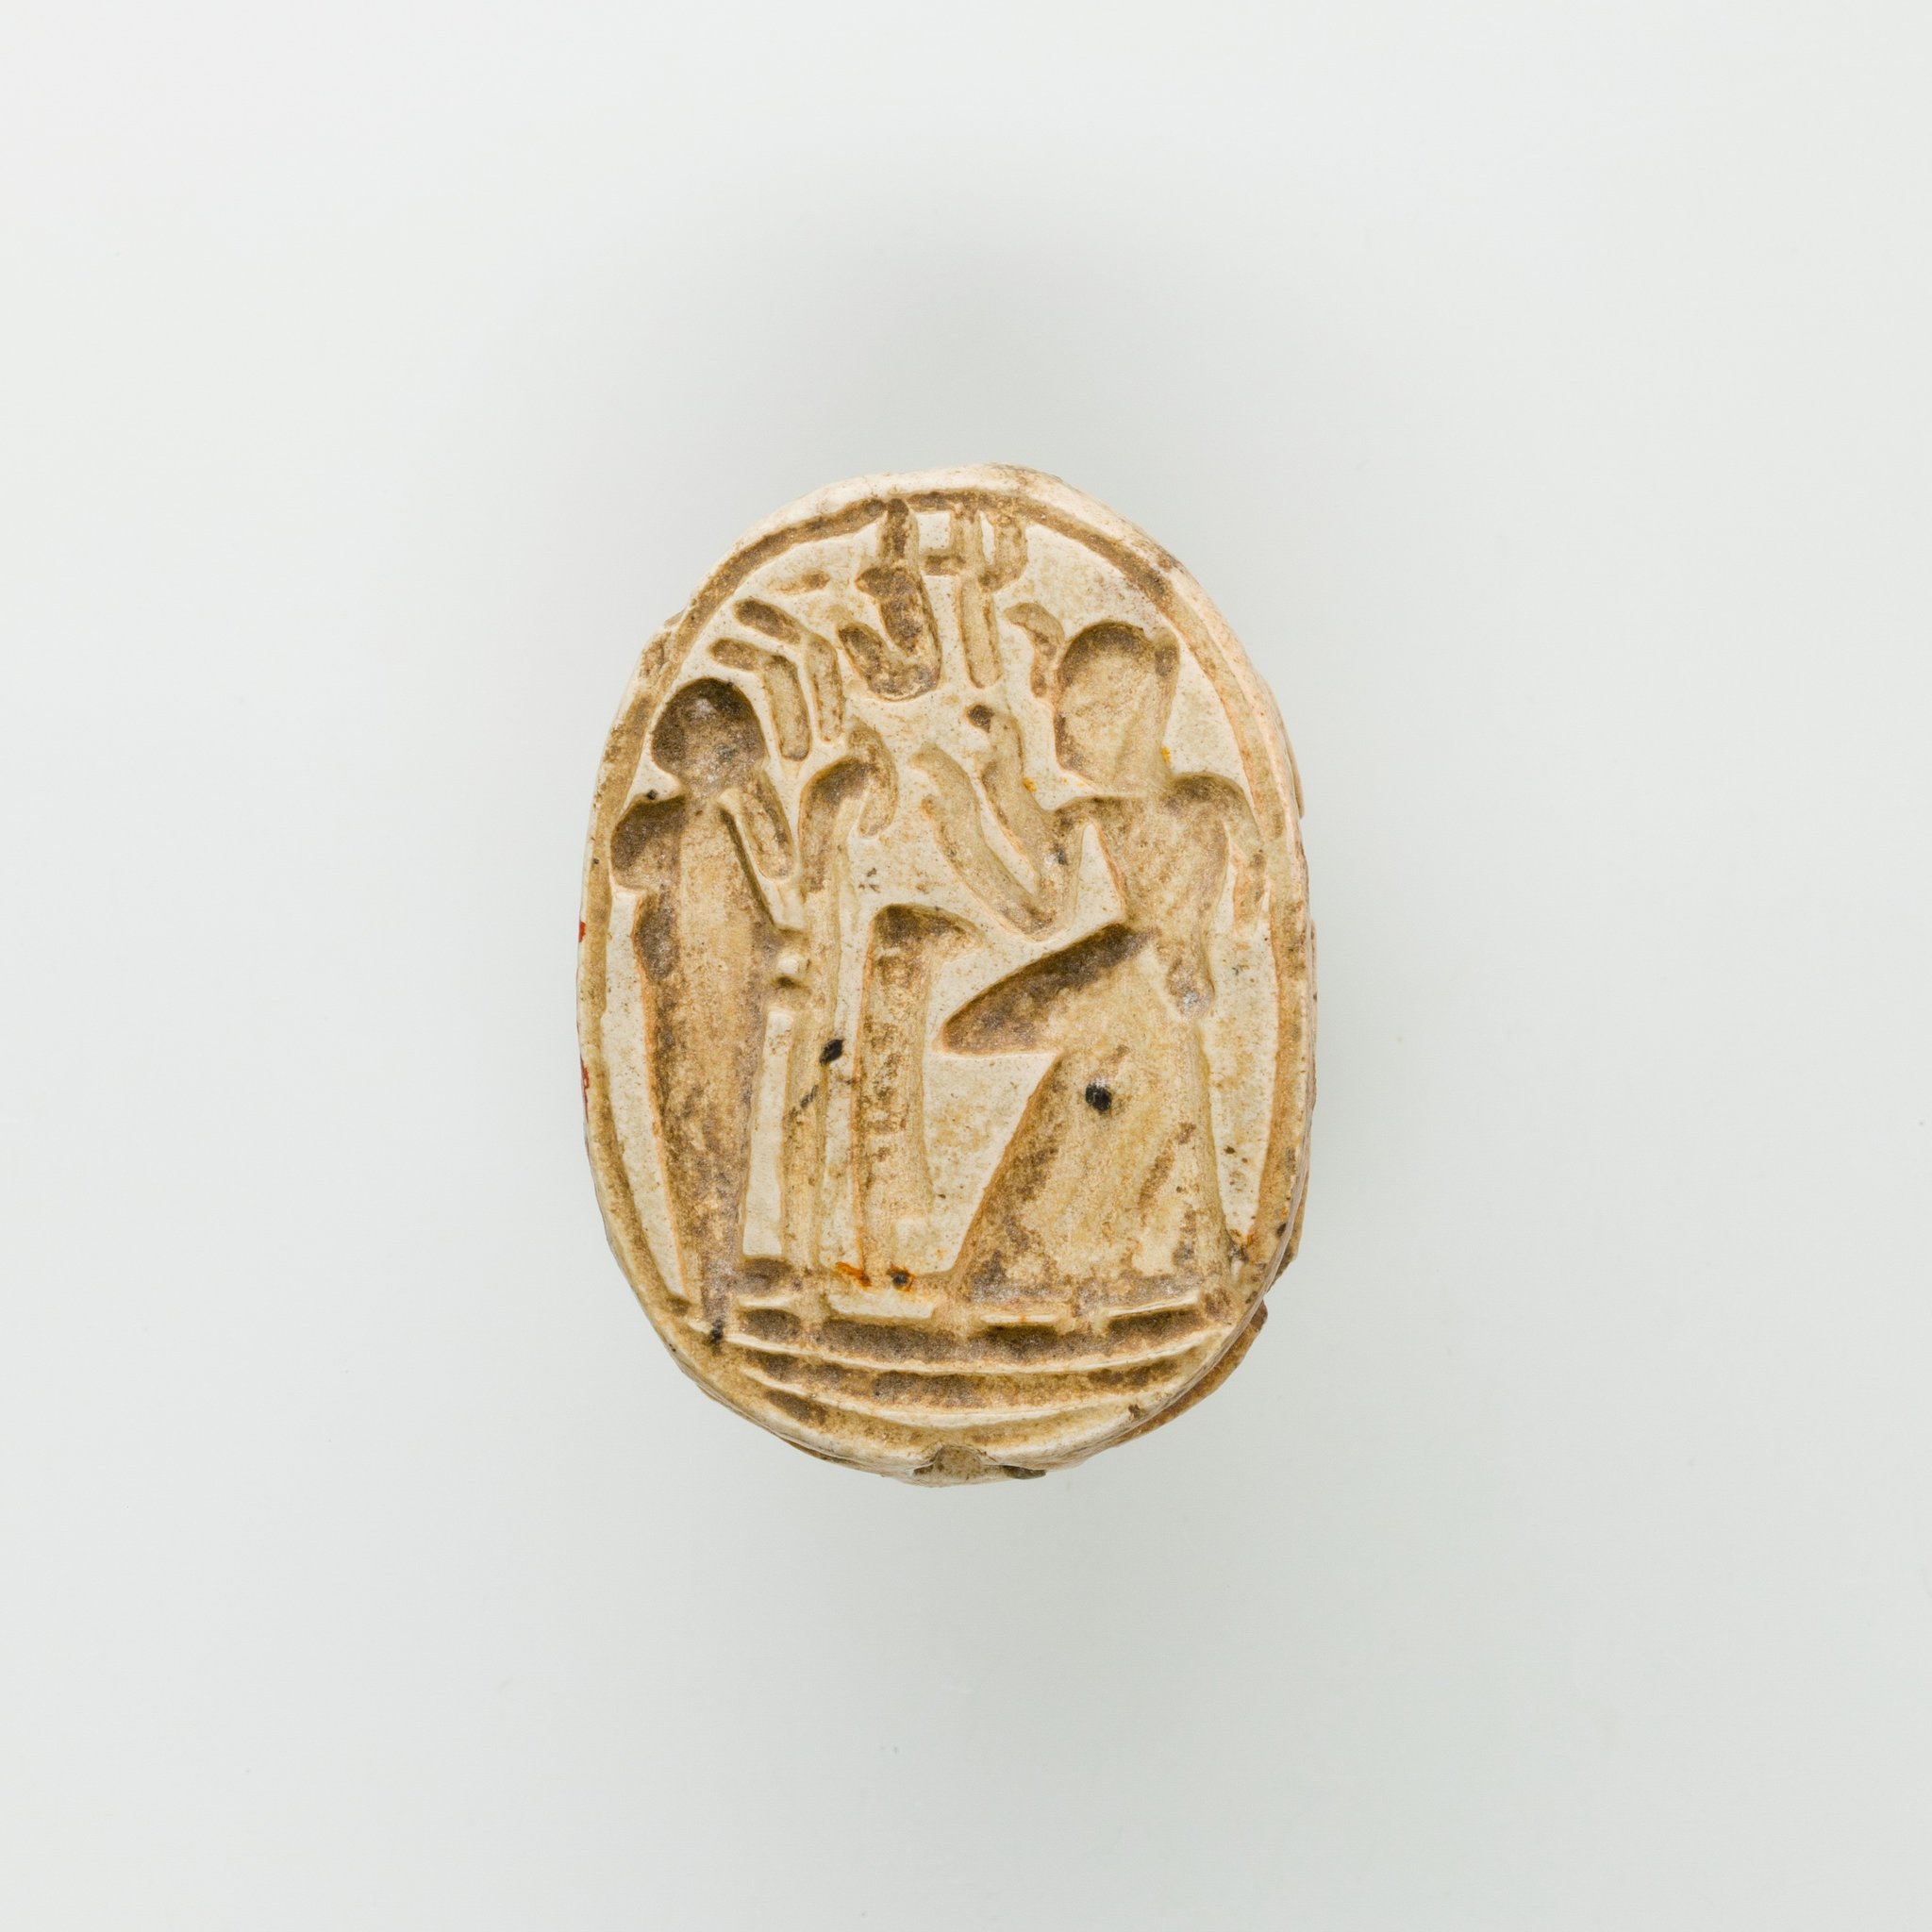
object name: scarab, ramesses ii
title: Scarab of Ramesses II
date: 1295-1070 BCE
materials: stone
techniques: glazing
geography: egypt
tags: scarabs